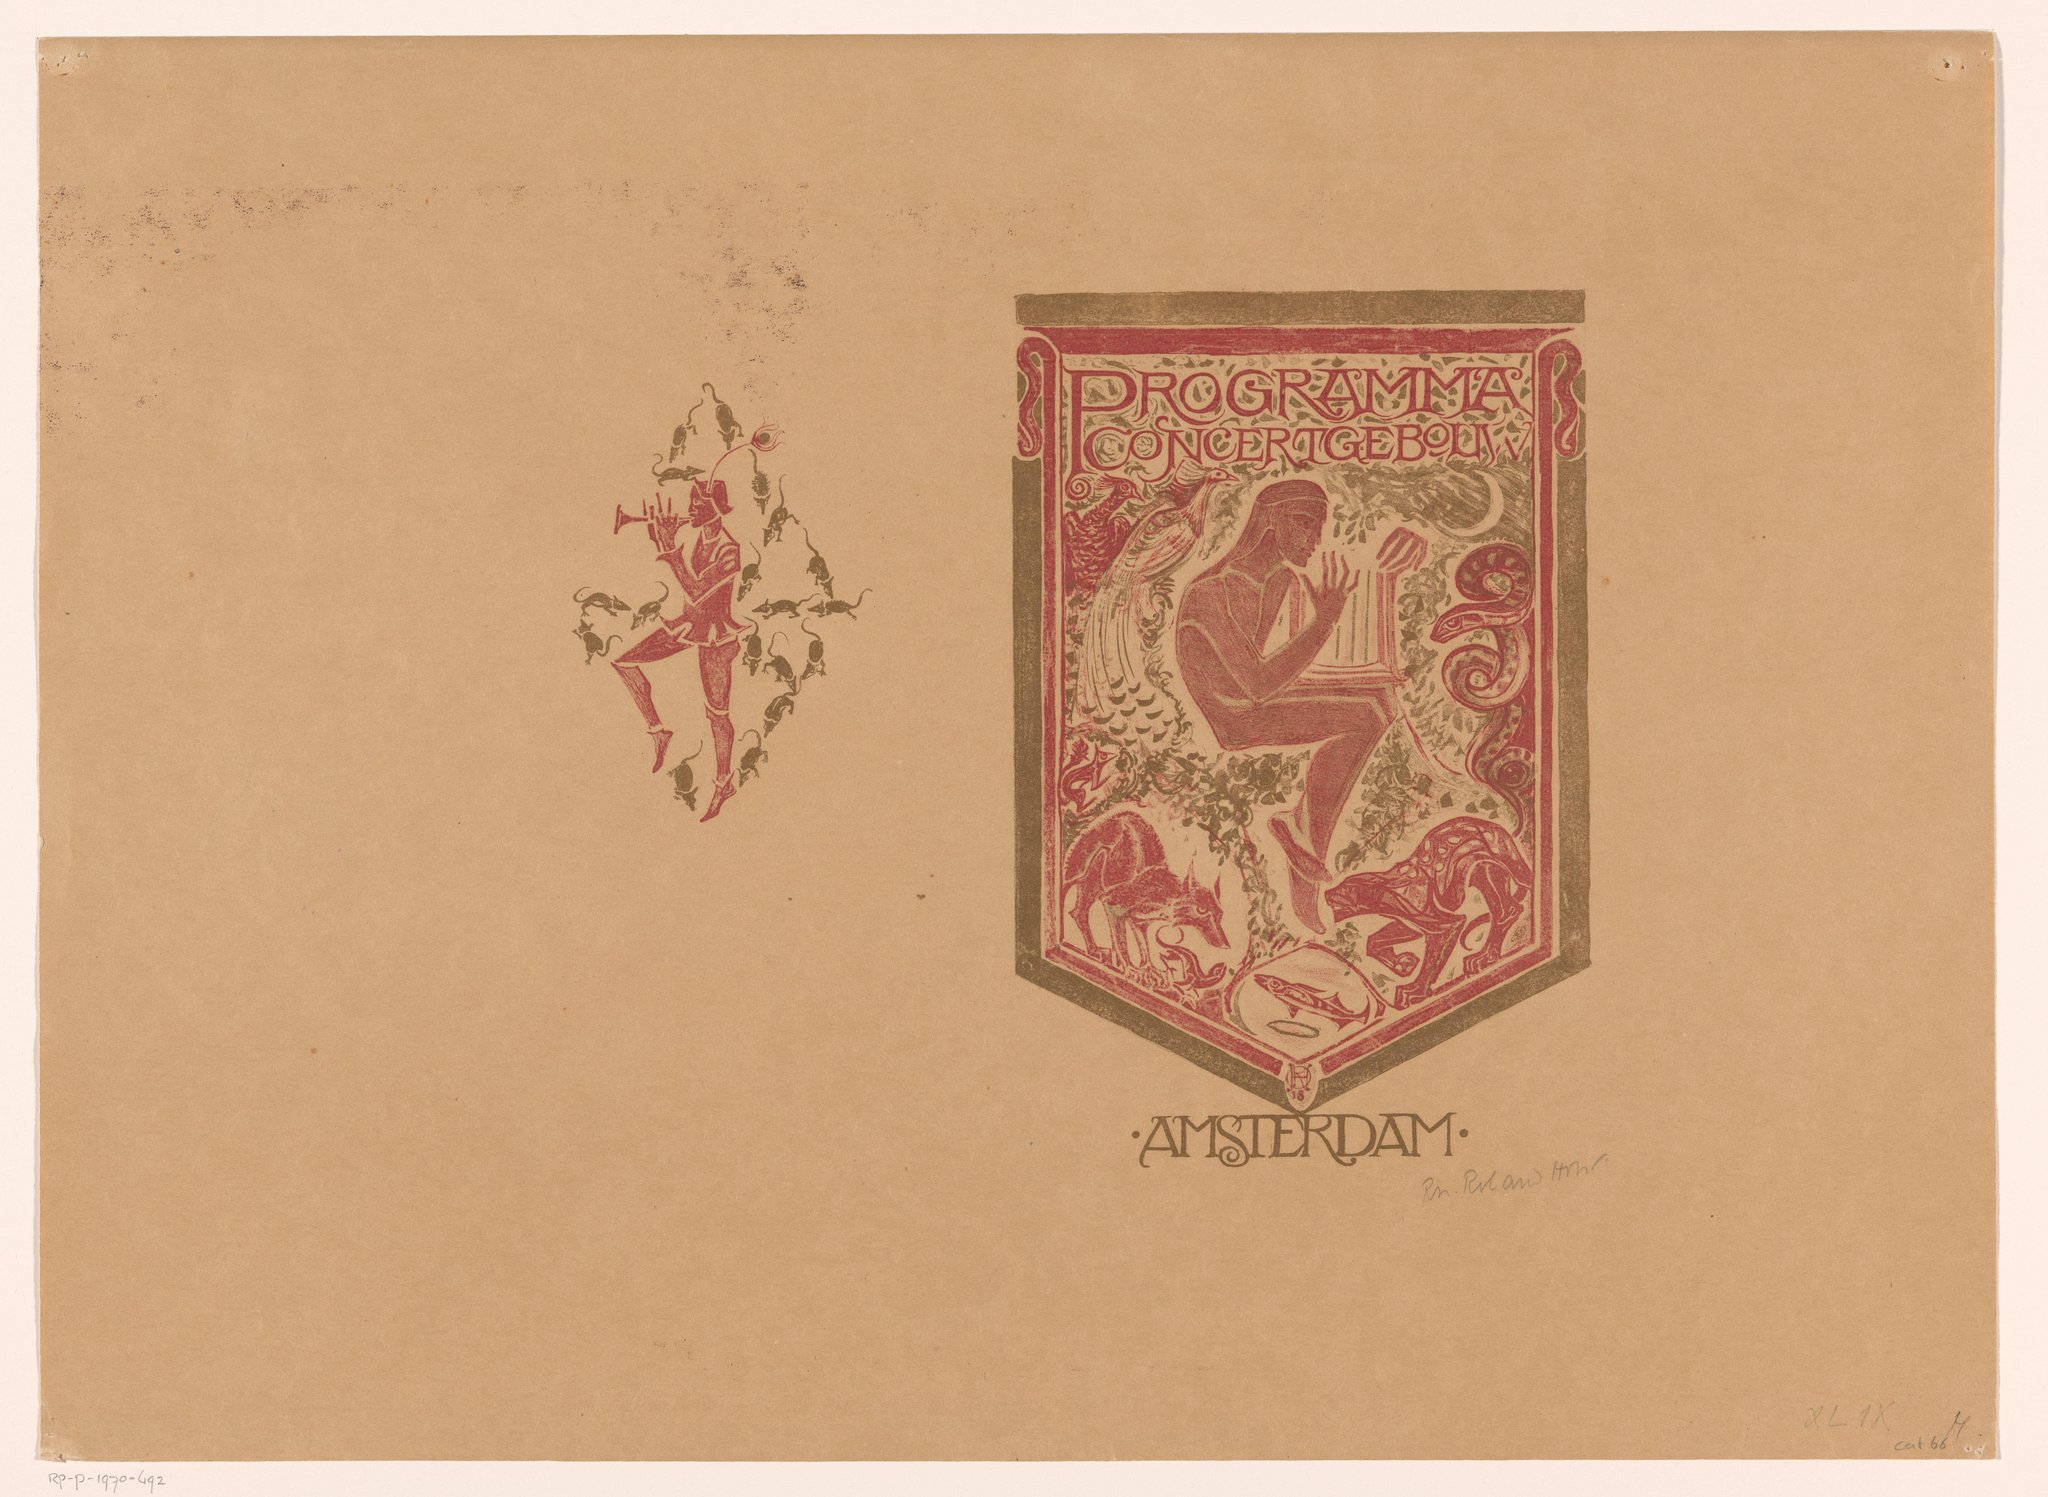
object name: wrapper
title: Omslagontwerp voor: Programma van het Concertgebouw Amsterdam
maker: richard nicolaüs roland holst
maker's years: 1868-1938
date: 1918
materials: paper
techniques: lithograph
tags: musician, animals, orpheus playing the lyre: trees and rocks move, beasts and birds are enchanted, rat exterminator, tales and fairy tales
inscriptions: collector's mark: Lugt 2228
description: Links de rattenvanger van Hamelen die zijn fluit bespeelt. De ratten die hij zodoende lokt zijn in een ruitvorm om hem heen geplaatst. Rechts Orpheus die op zijn harp speelt in het gezelschap van verschillende dieren.